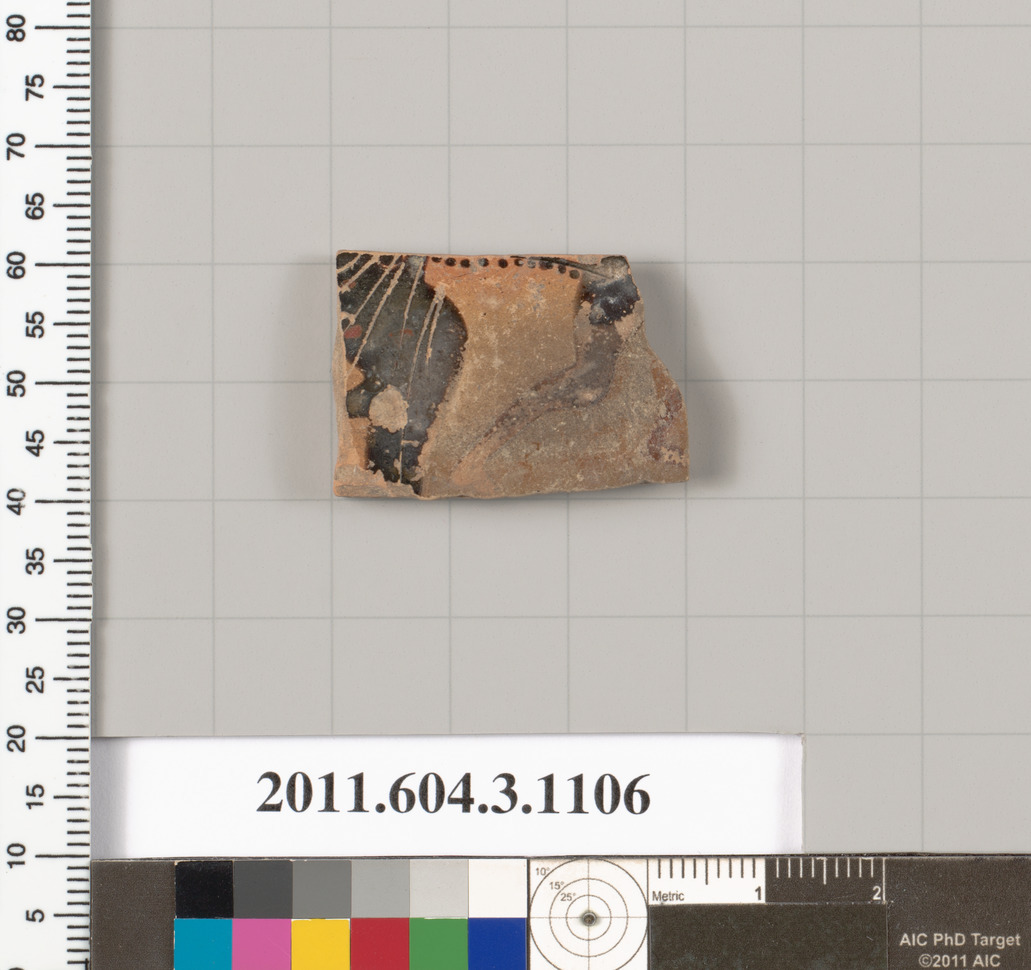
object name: mastoid or kyathos fragment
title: Terracotta fragment of a mastoid (drinking cup with narrow base) or a kyathos (cup-shaped ladle)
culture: greek, attic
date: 534-468 BCE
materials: terracotta